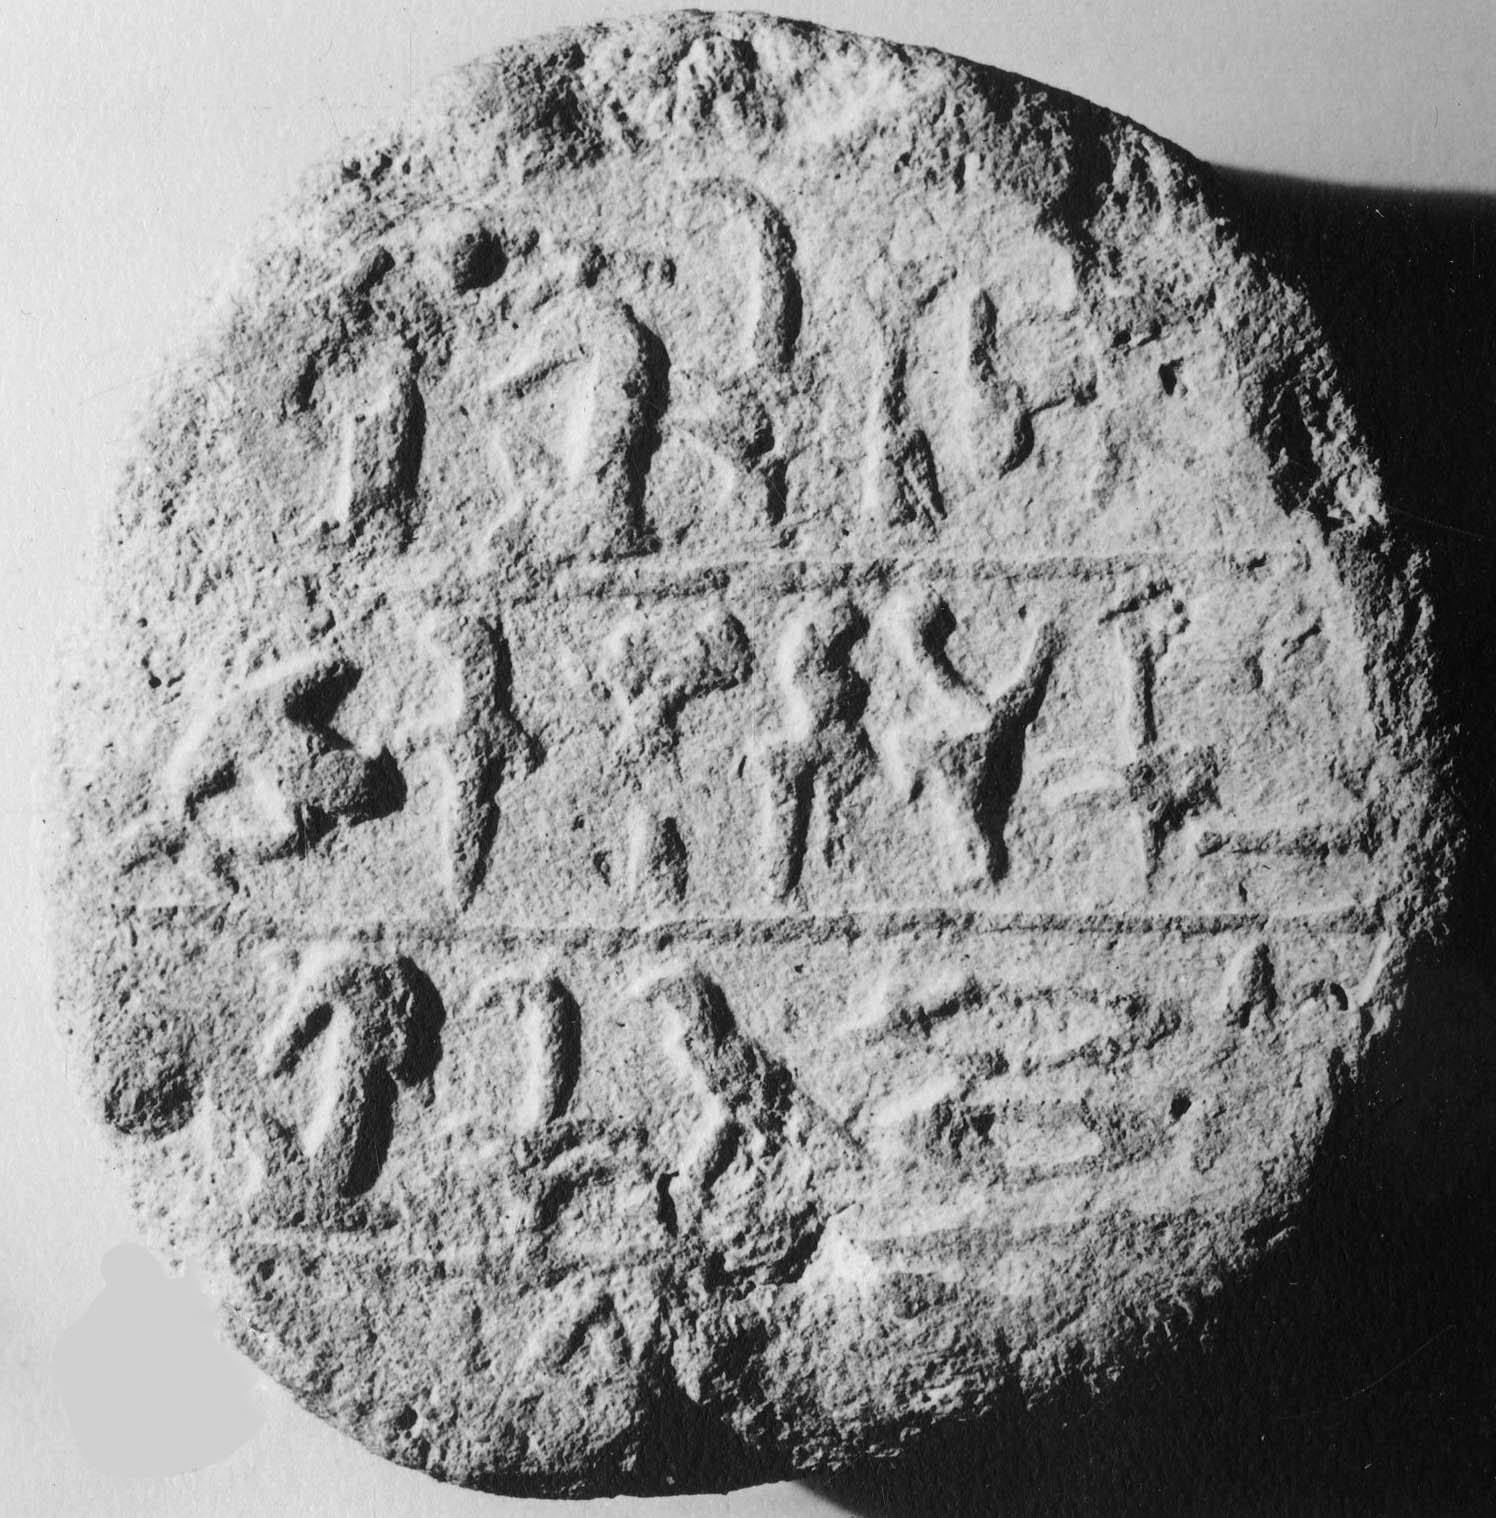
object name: cone, round, surer, royal scribe, fanbearer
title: Funerary Cone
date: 1550-1295 BCE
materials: pottery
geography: egypt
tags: hieroglyphs